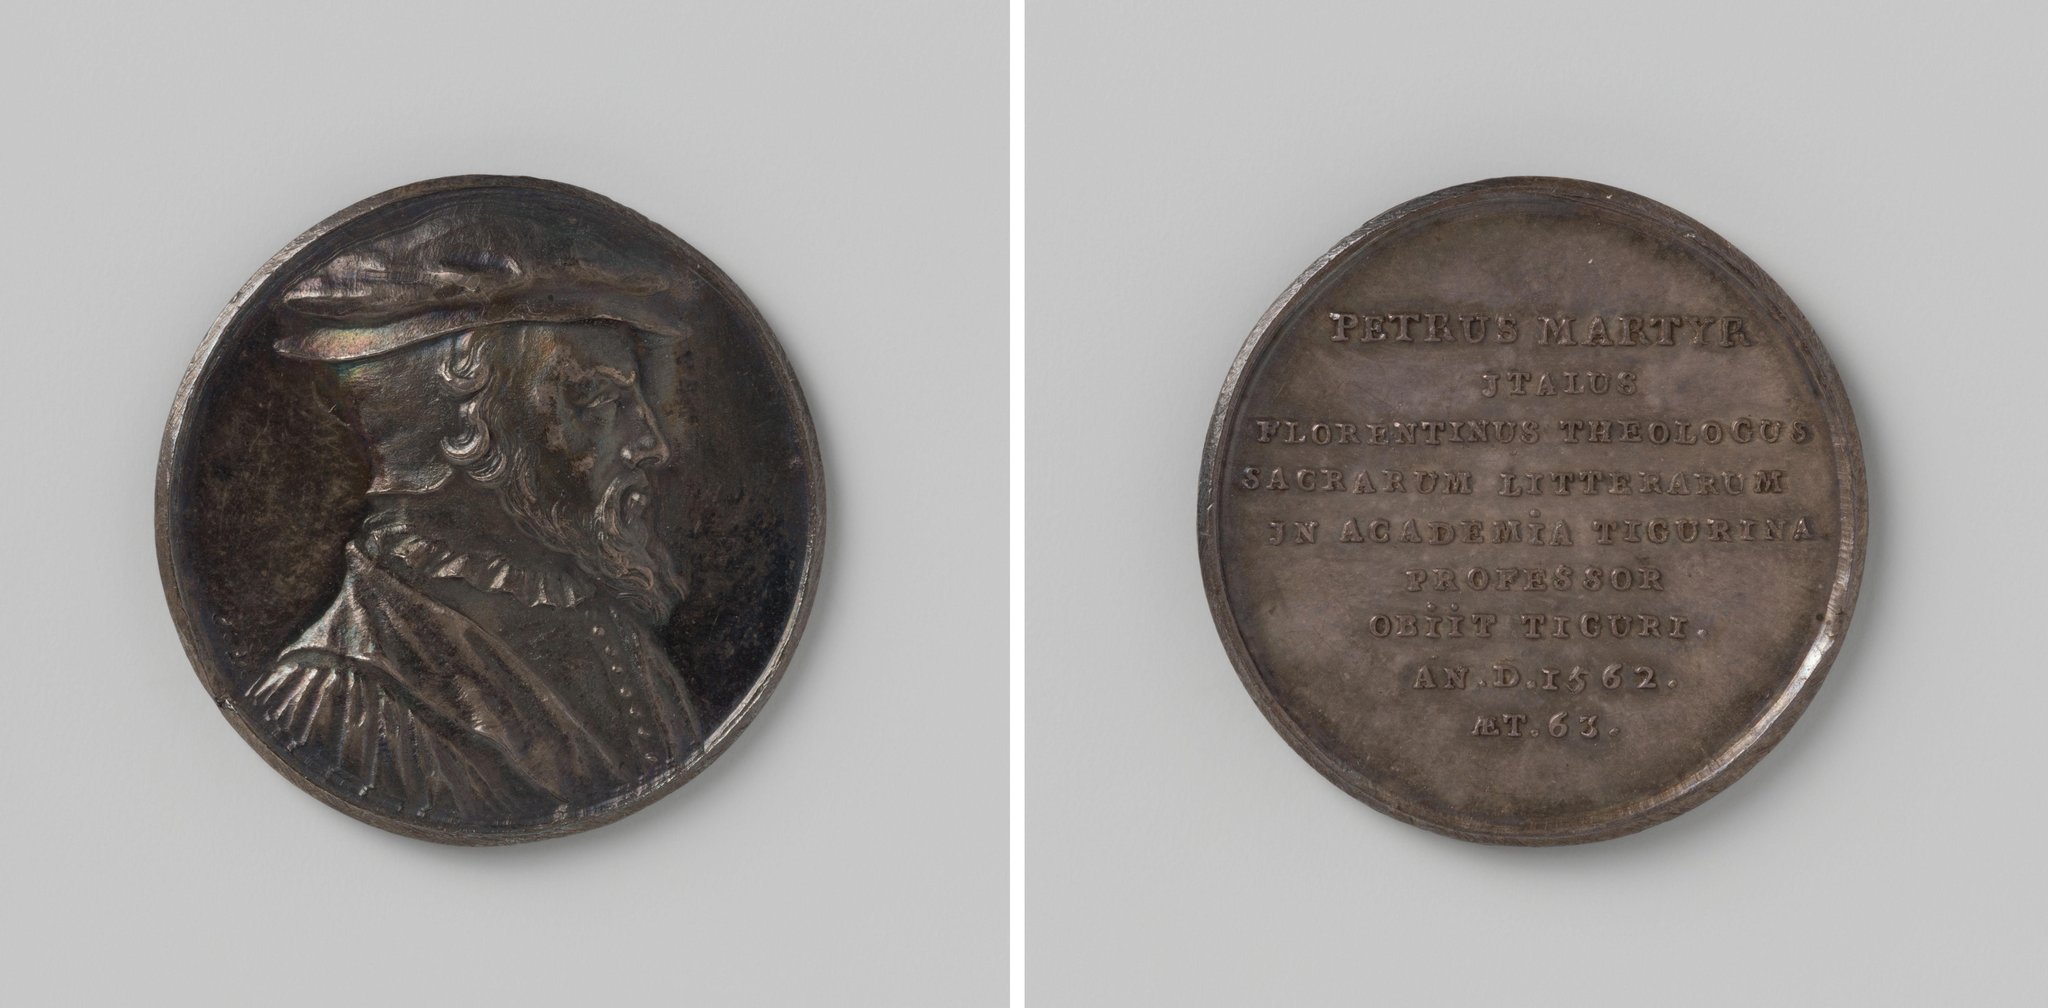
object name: history medal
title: Overlijden van Petrus Martyr, hervormer in Italië, Zwitserland en Frankrijk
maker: jean dassier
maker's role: medailleur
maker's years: 1676-1763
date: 1725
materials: silver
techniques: striking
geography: geneva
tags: italy, france, switzerland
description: Zilveren penning. Voorzijde: borststuk man. Keerzijde: opschrift